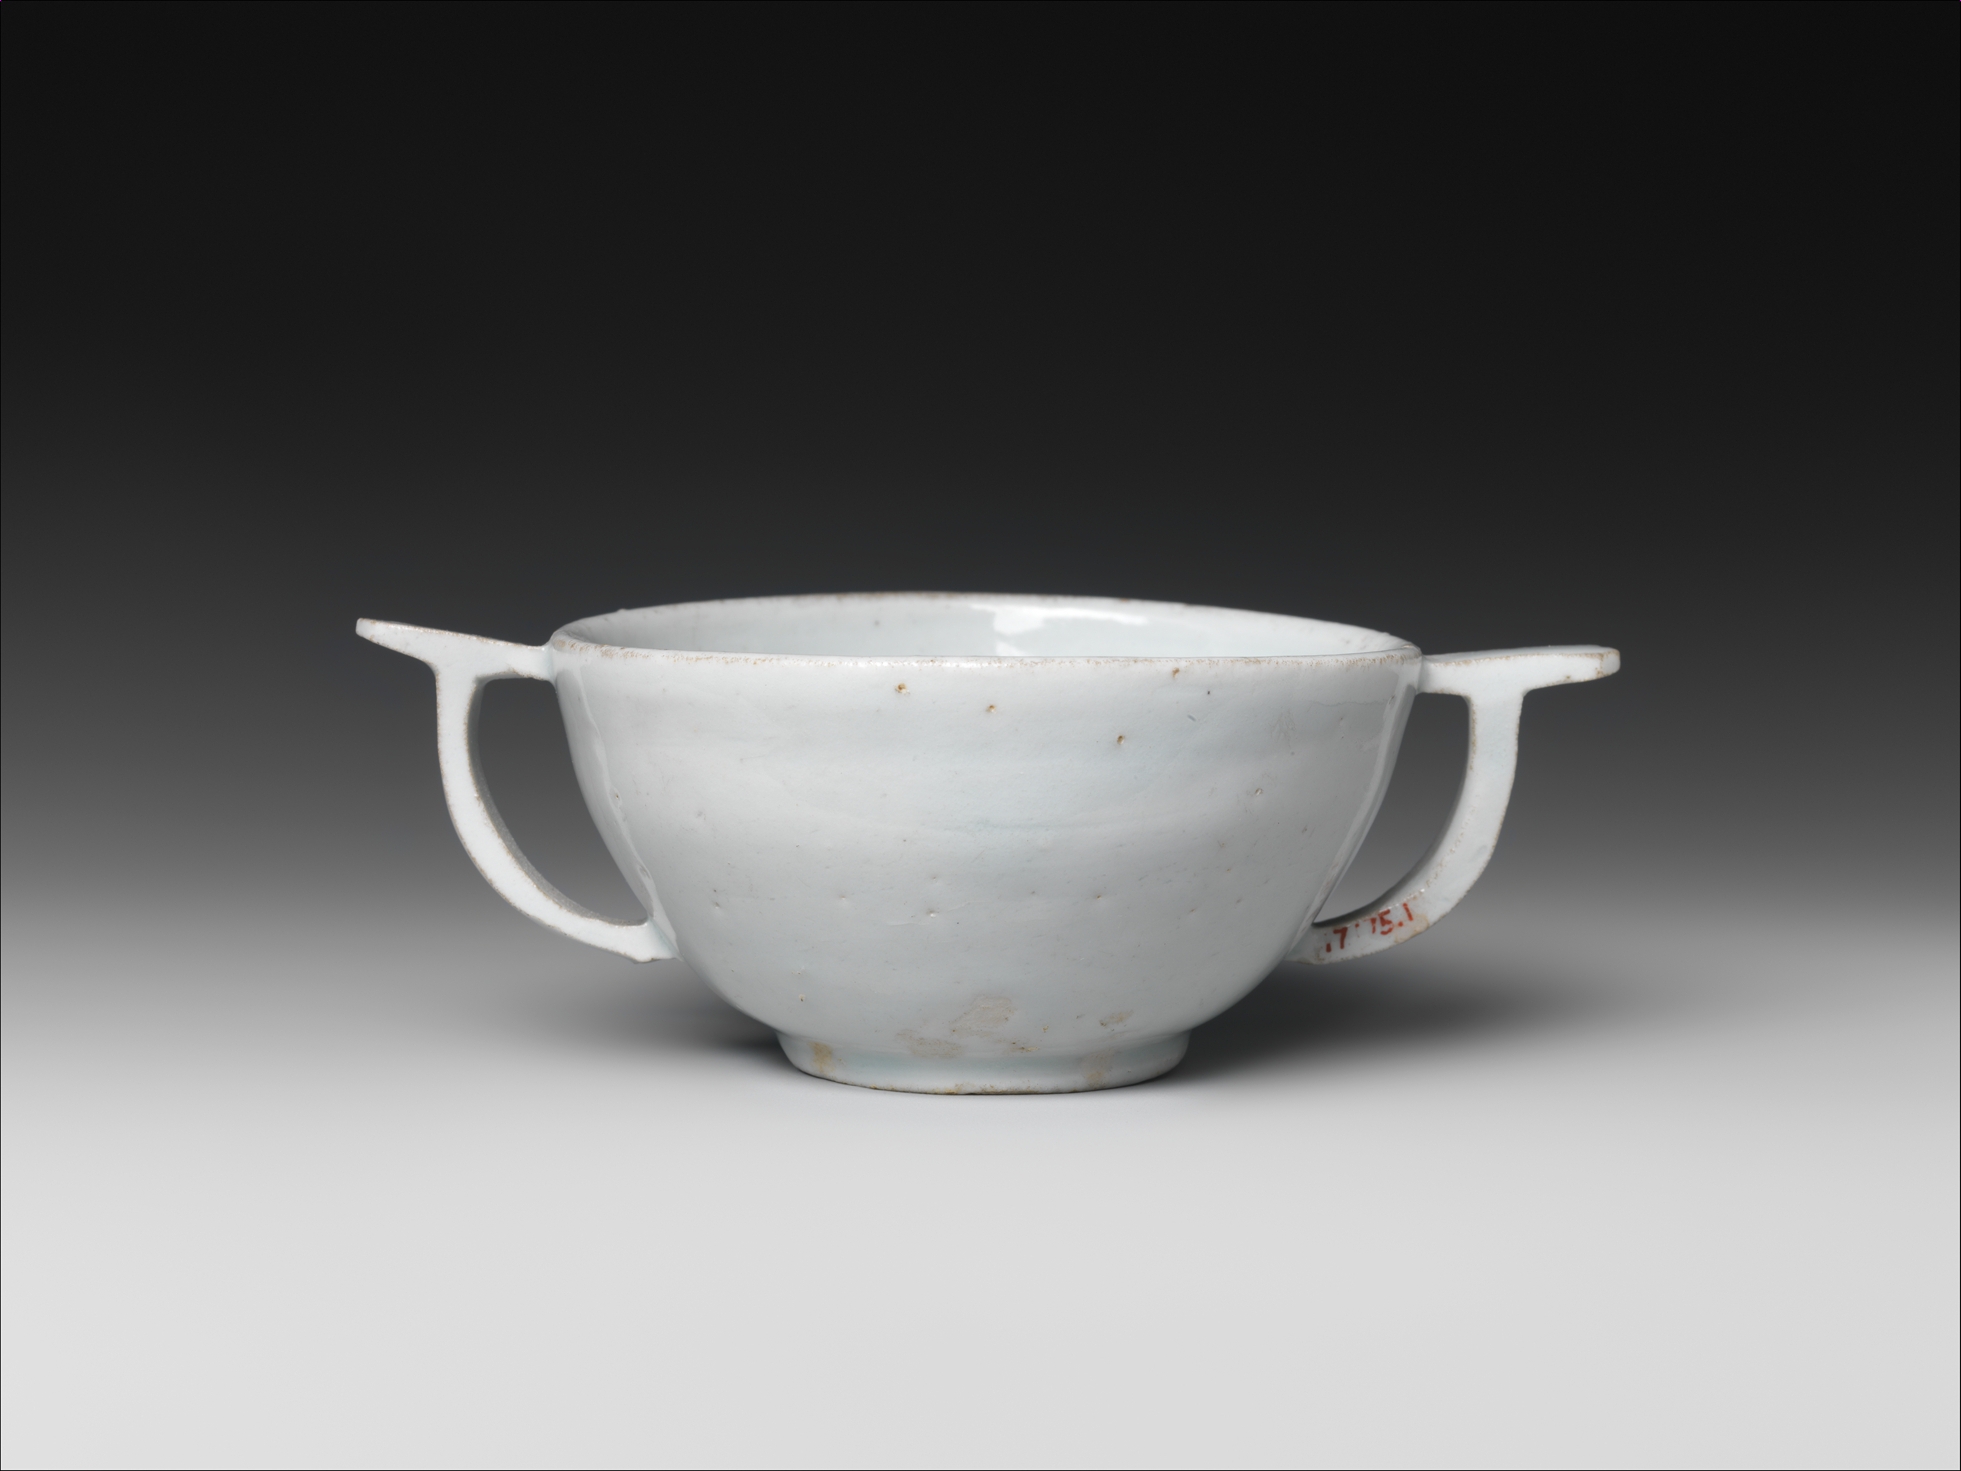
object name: wine cup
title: Wine cup with ear handles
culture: korean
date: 1401-1500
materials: porcelain